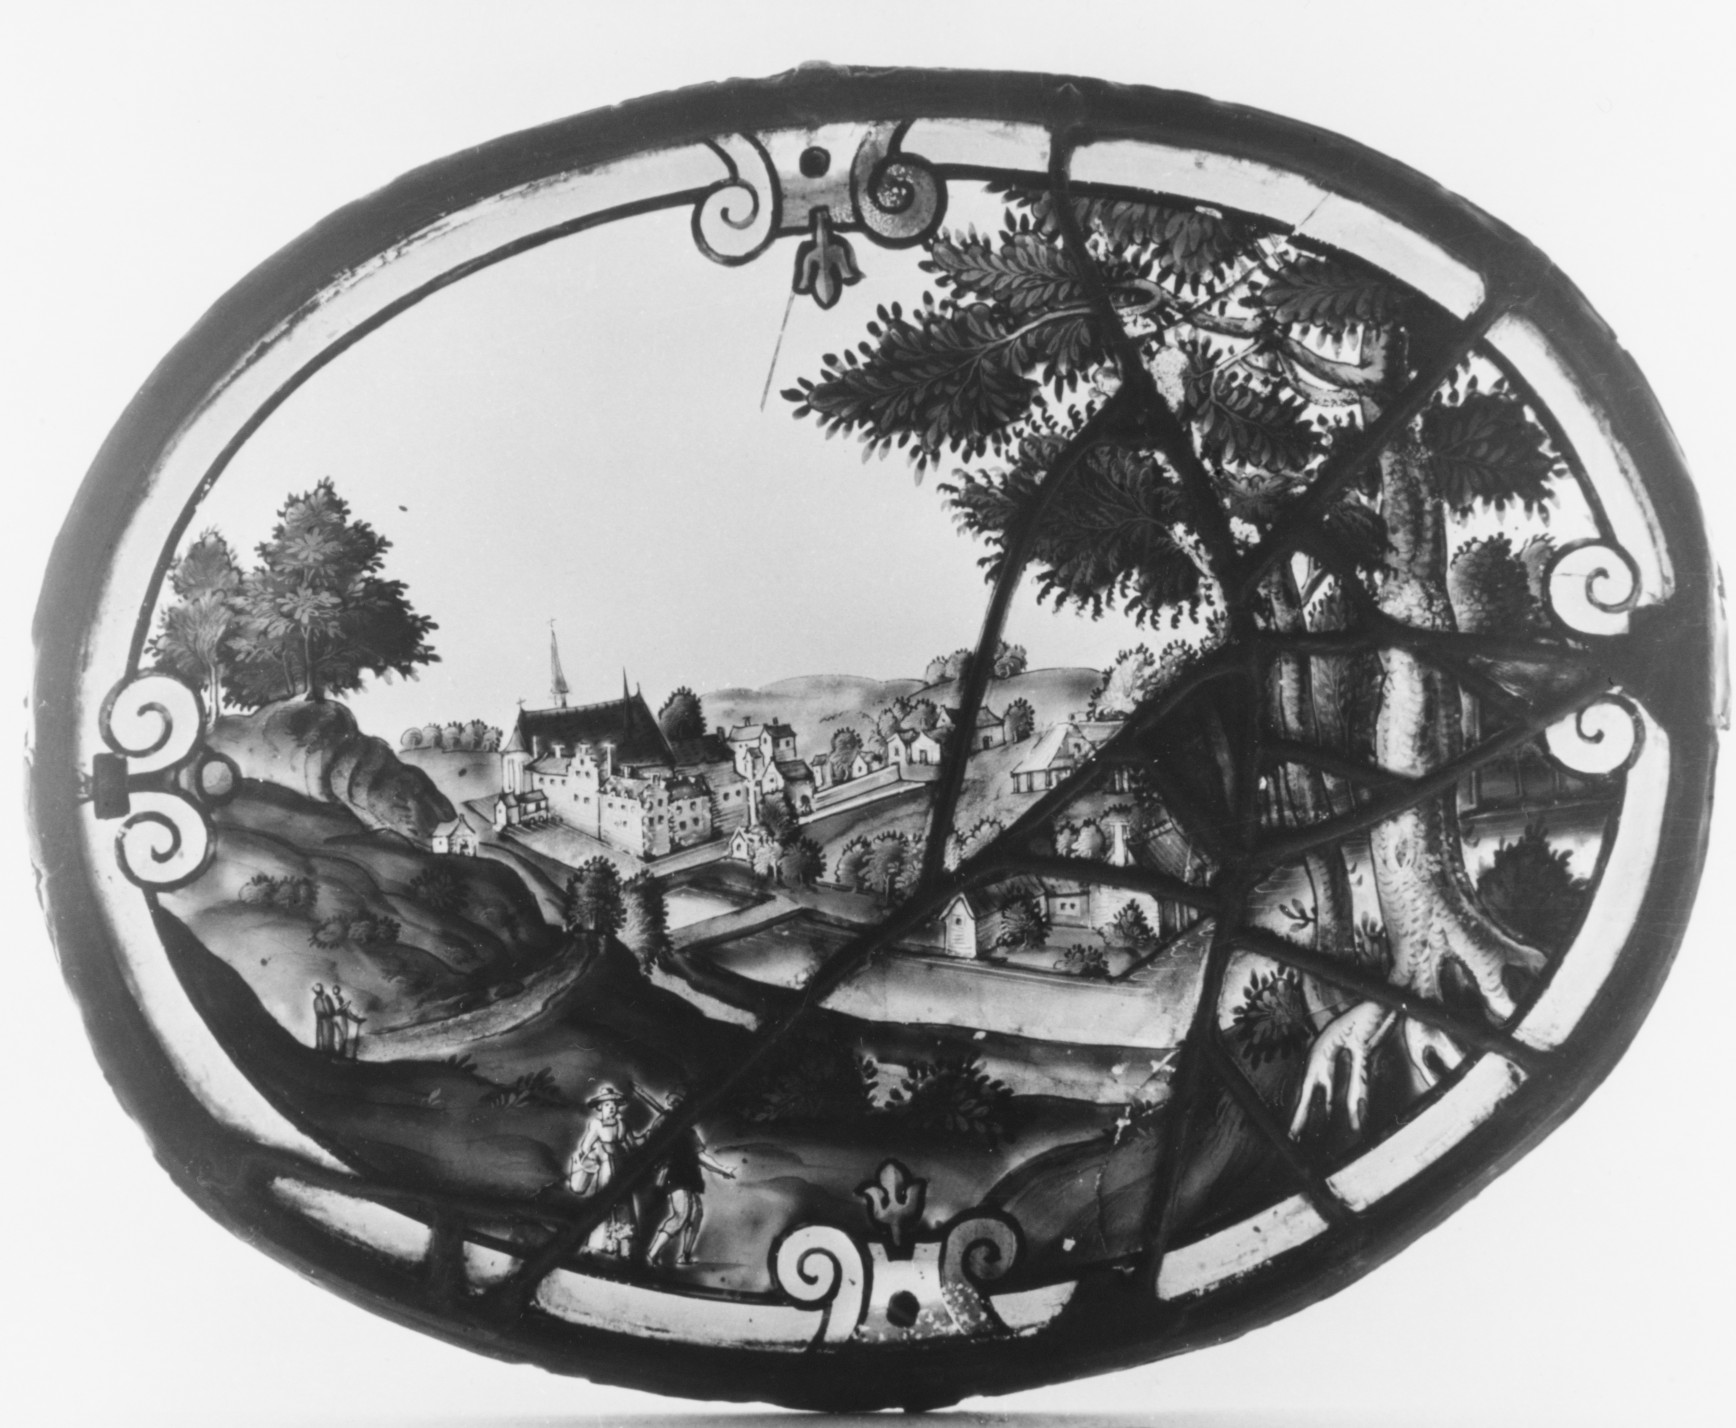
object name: panel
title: Landscape with view of the Monastery of Zevenburren near Louvain (one of three)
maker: collaert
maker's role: artist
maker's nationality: flemish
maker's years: 1566-1626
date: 1601-1633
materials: glass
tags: landscapes,trees